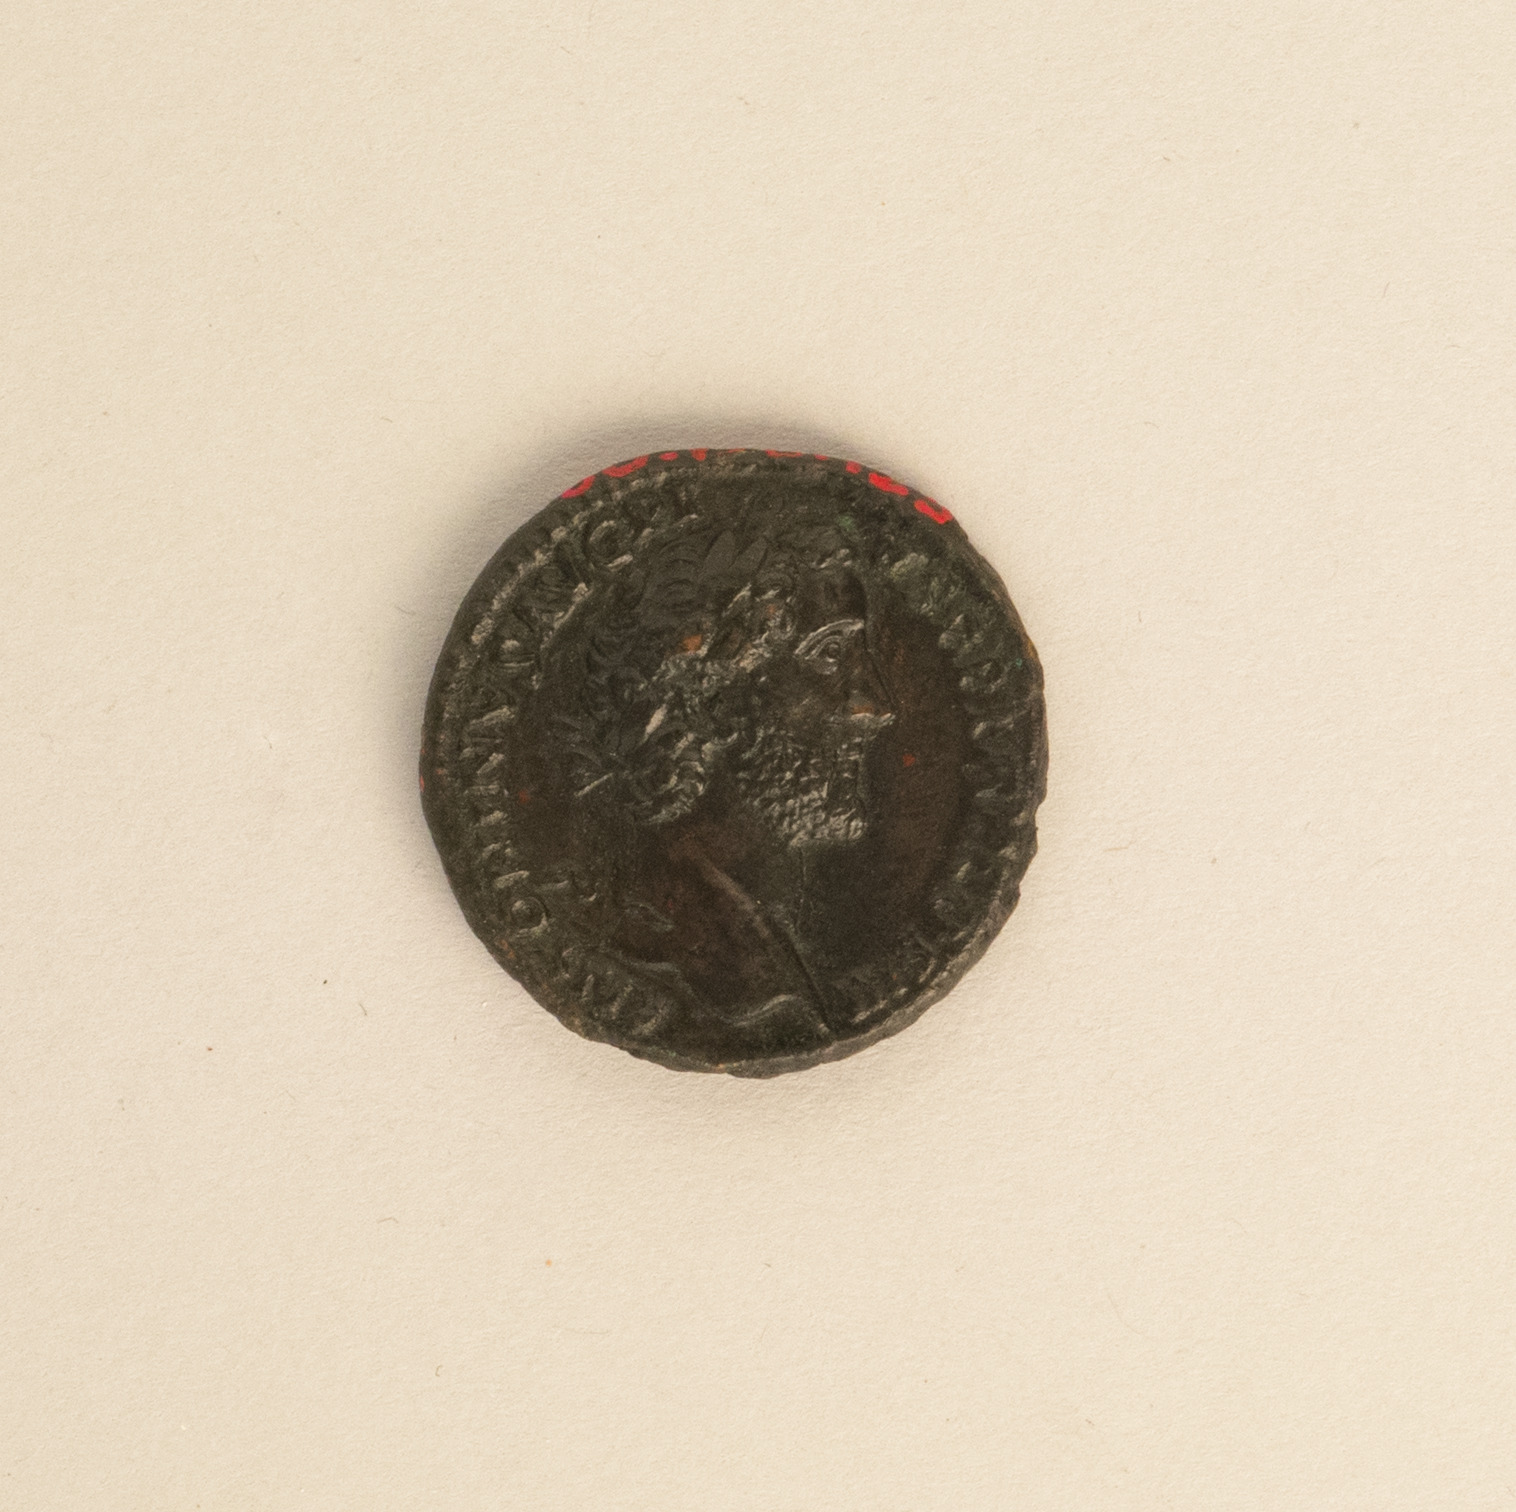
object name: dupondius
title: Bronze as of Antoninus Pius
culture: roman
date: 143-144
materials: bronze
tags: men,profiles